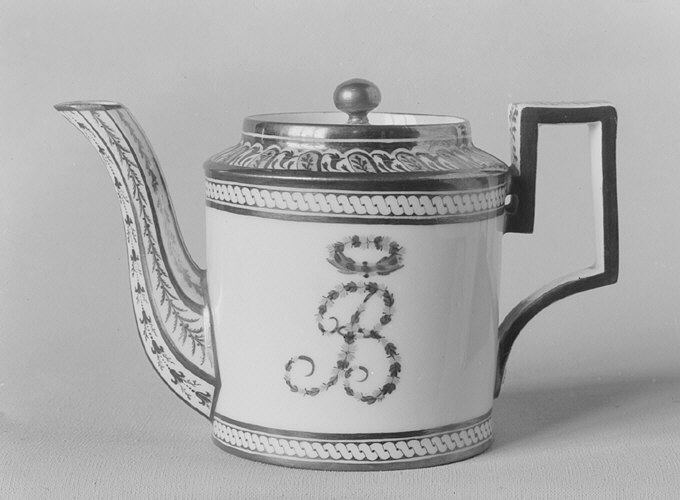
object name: teapot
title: Teapot (part of a traveling tea service)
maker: dihl et guérhard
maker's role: factory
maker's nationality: french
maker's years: 1781-1824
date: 1788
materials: hard paste porcelain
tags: garlands,insignia